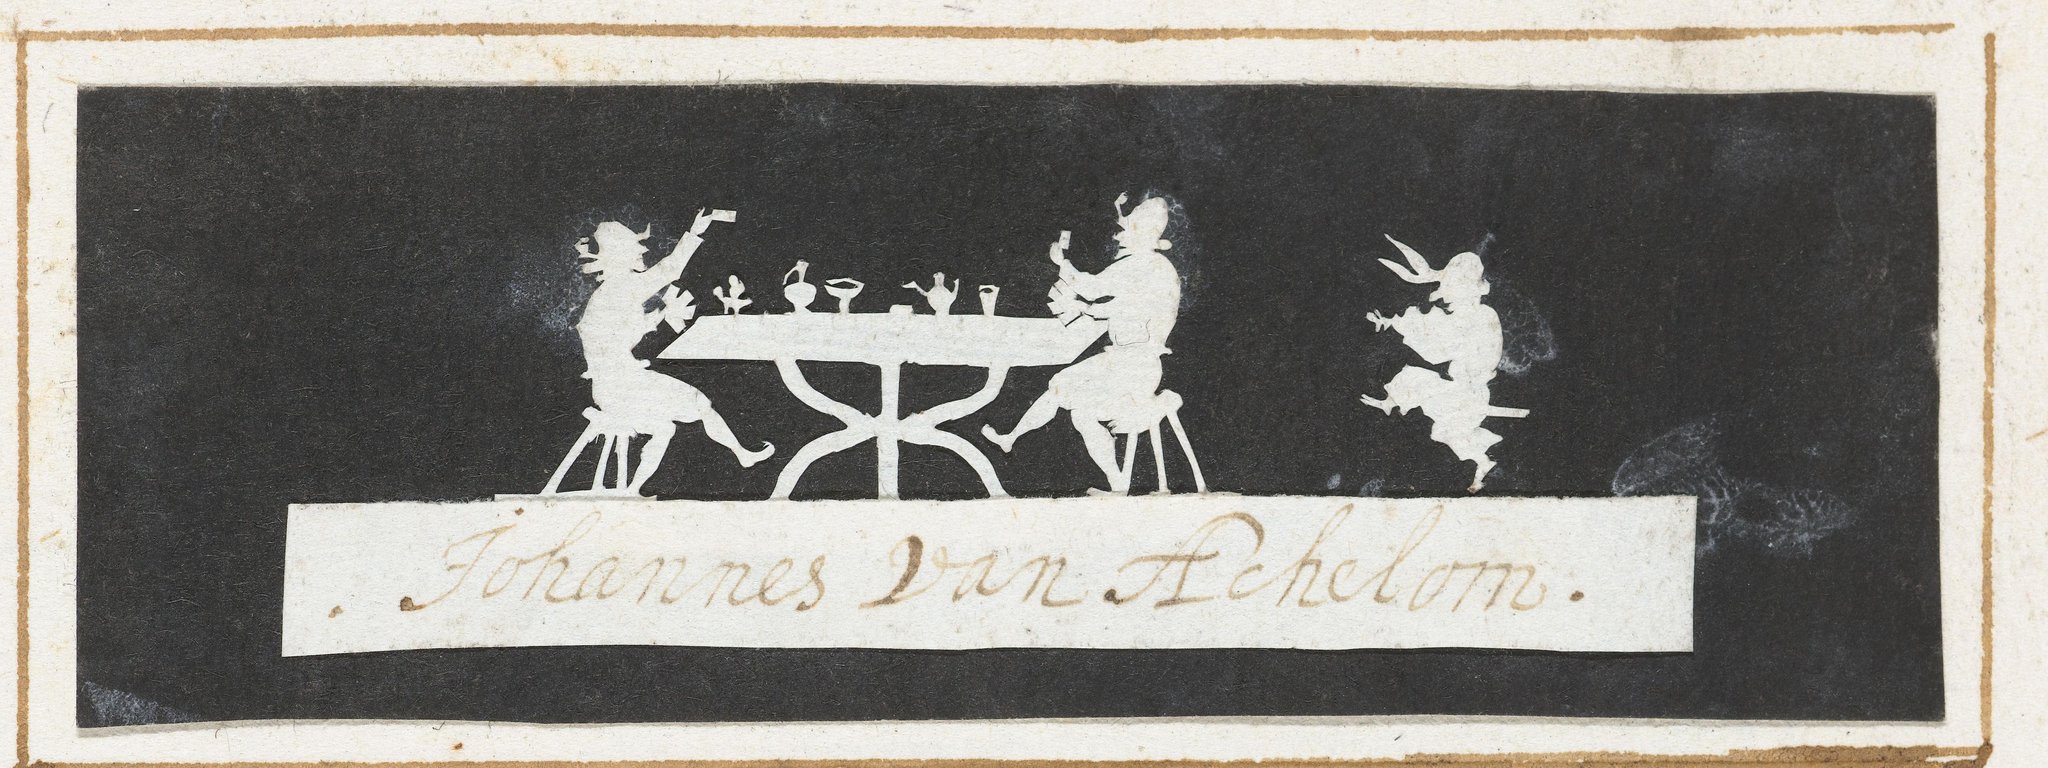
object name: cut paper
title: Twee drinkers aan een tafel en een bediende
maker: johannes van achelom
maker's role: knipkunstenaar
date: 1685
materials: paper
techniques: snipping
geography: amsterdam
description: Witte knipsels op een zwart papier, samen met drie andere knipselkunstwerken op een blad geplakt in het Plakboek.